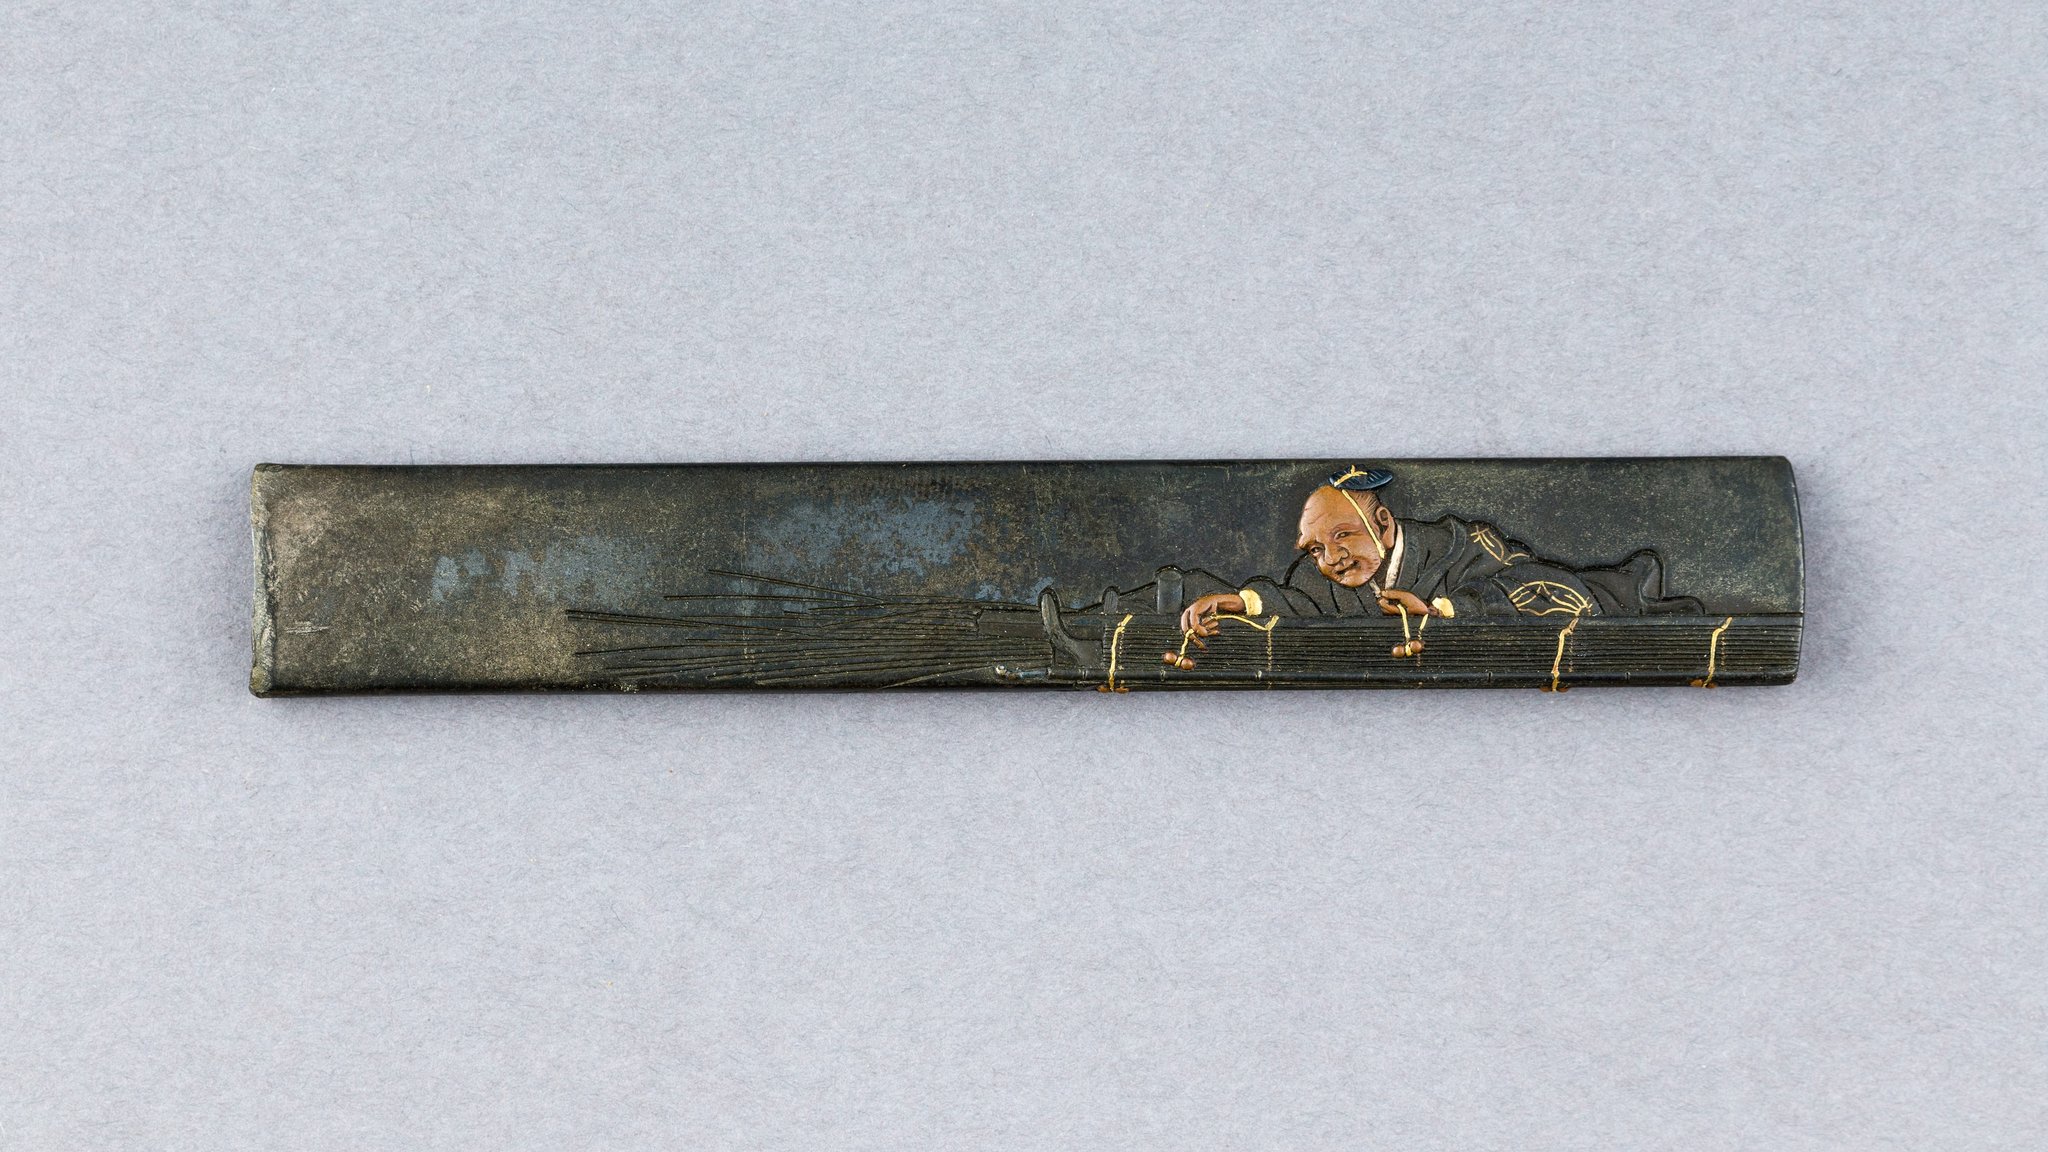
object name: knife handle kozuka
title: Knife Handle (Kozuka)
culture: japanese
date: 1615-1868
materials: copper, gold alloy, gold, silver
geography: japan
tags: men